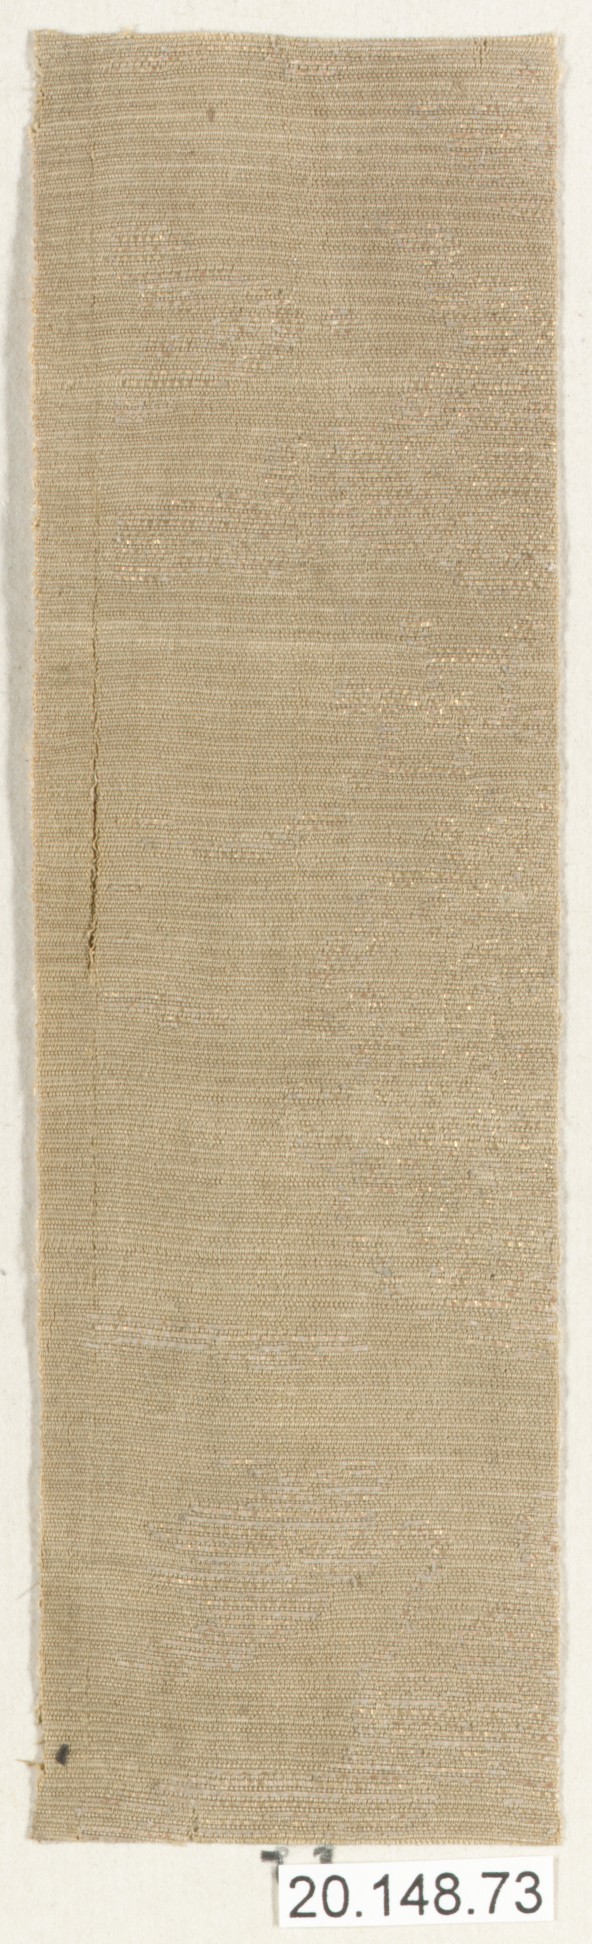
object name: piece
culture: japanese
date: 1001-1100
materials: silk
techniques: compound weave